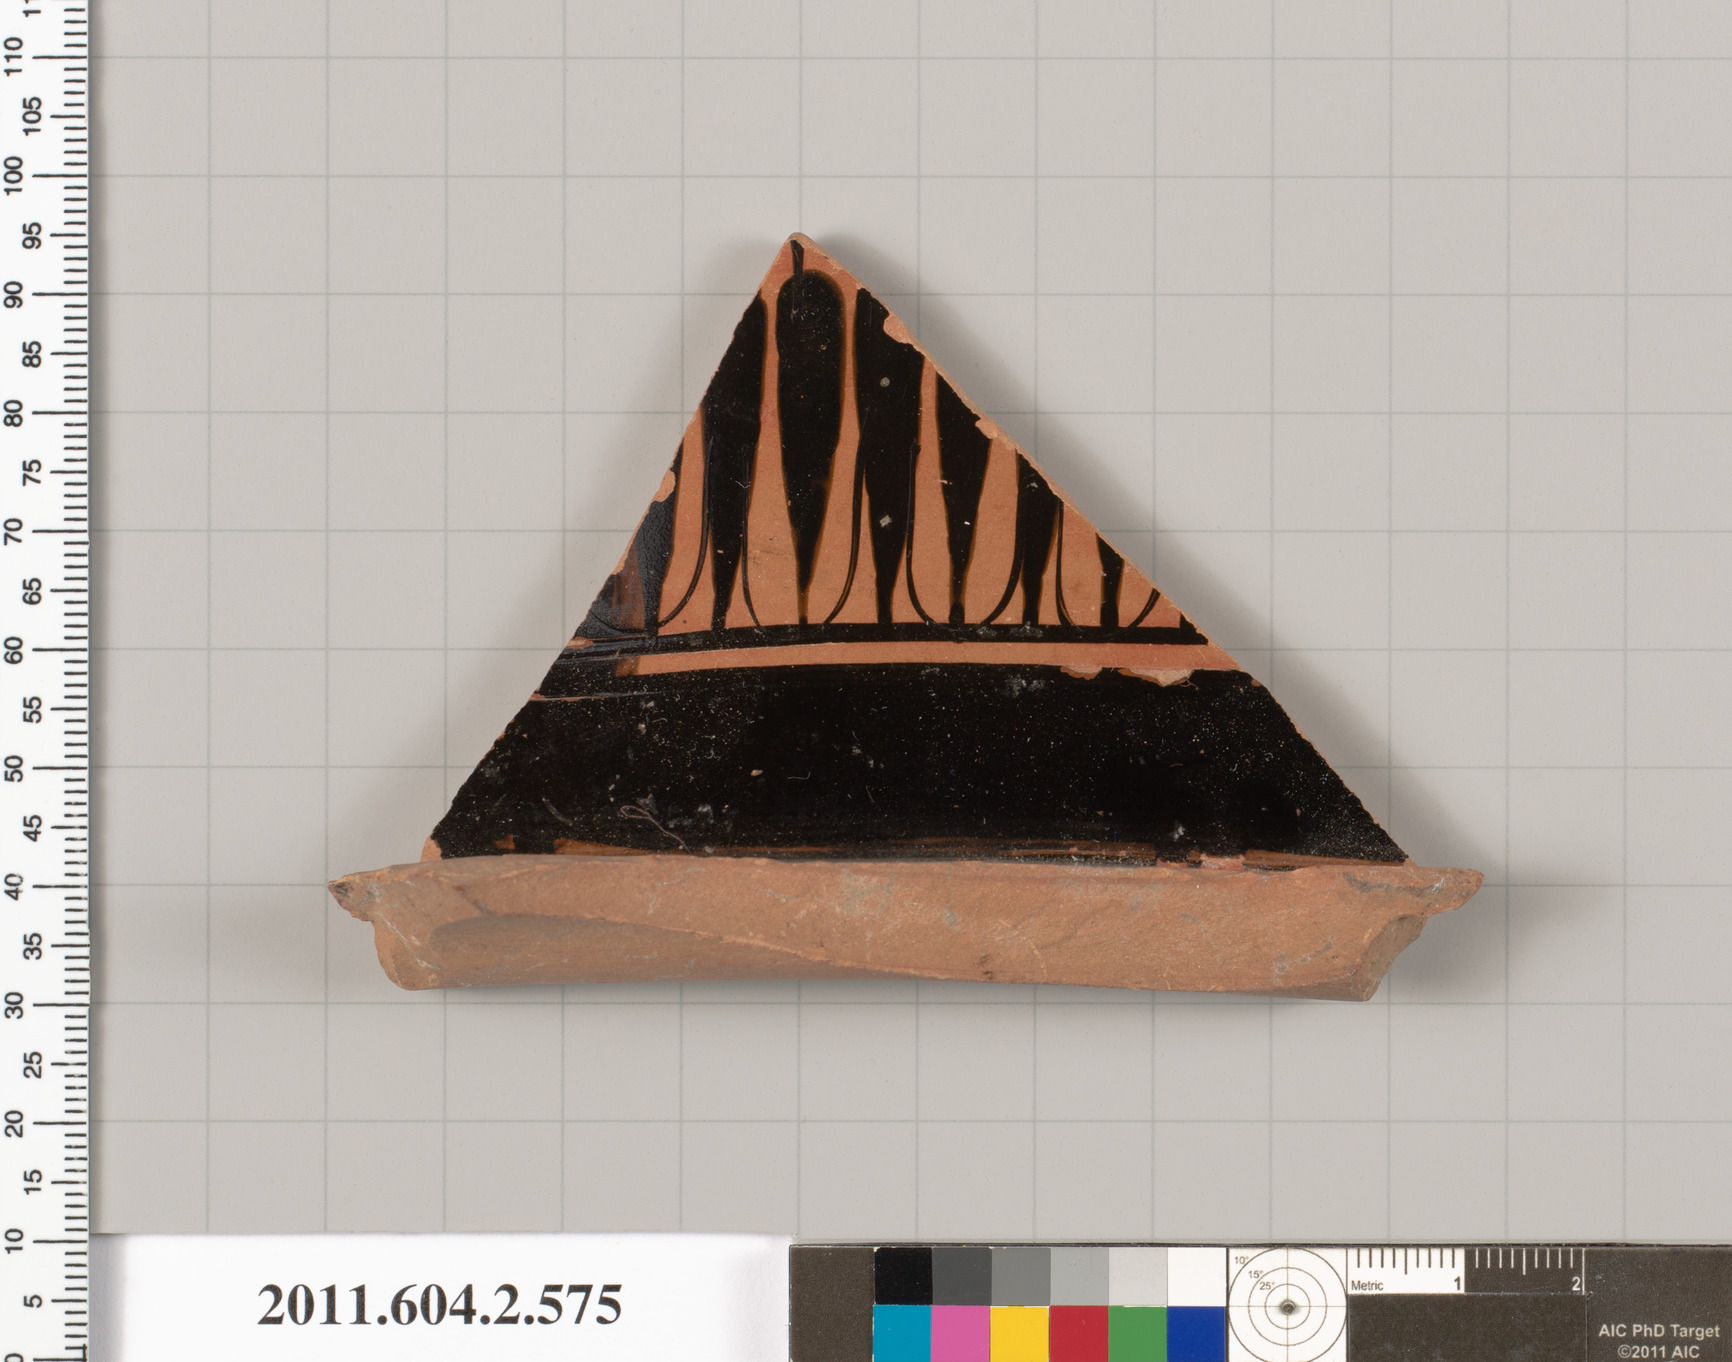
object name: column krater fragment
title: Terracotta fragment of a column-krater (bowl for mixing wine and water)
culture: greek, attic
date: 460-440 BCE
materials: terracotta